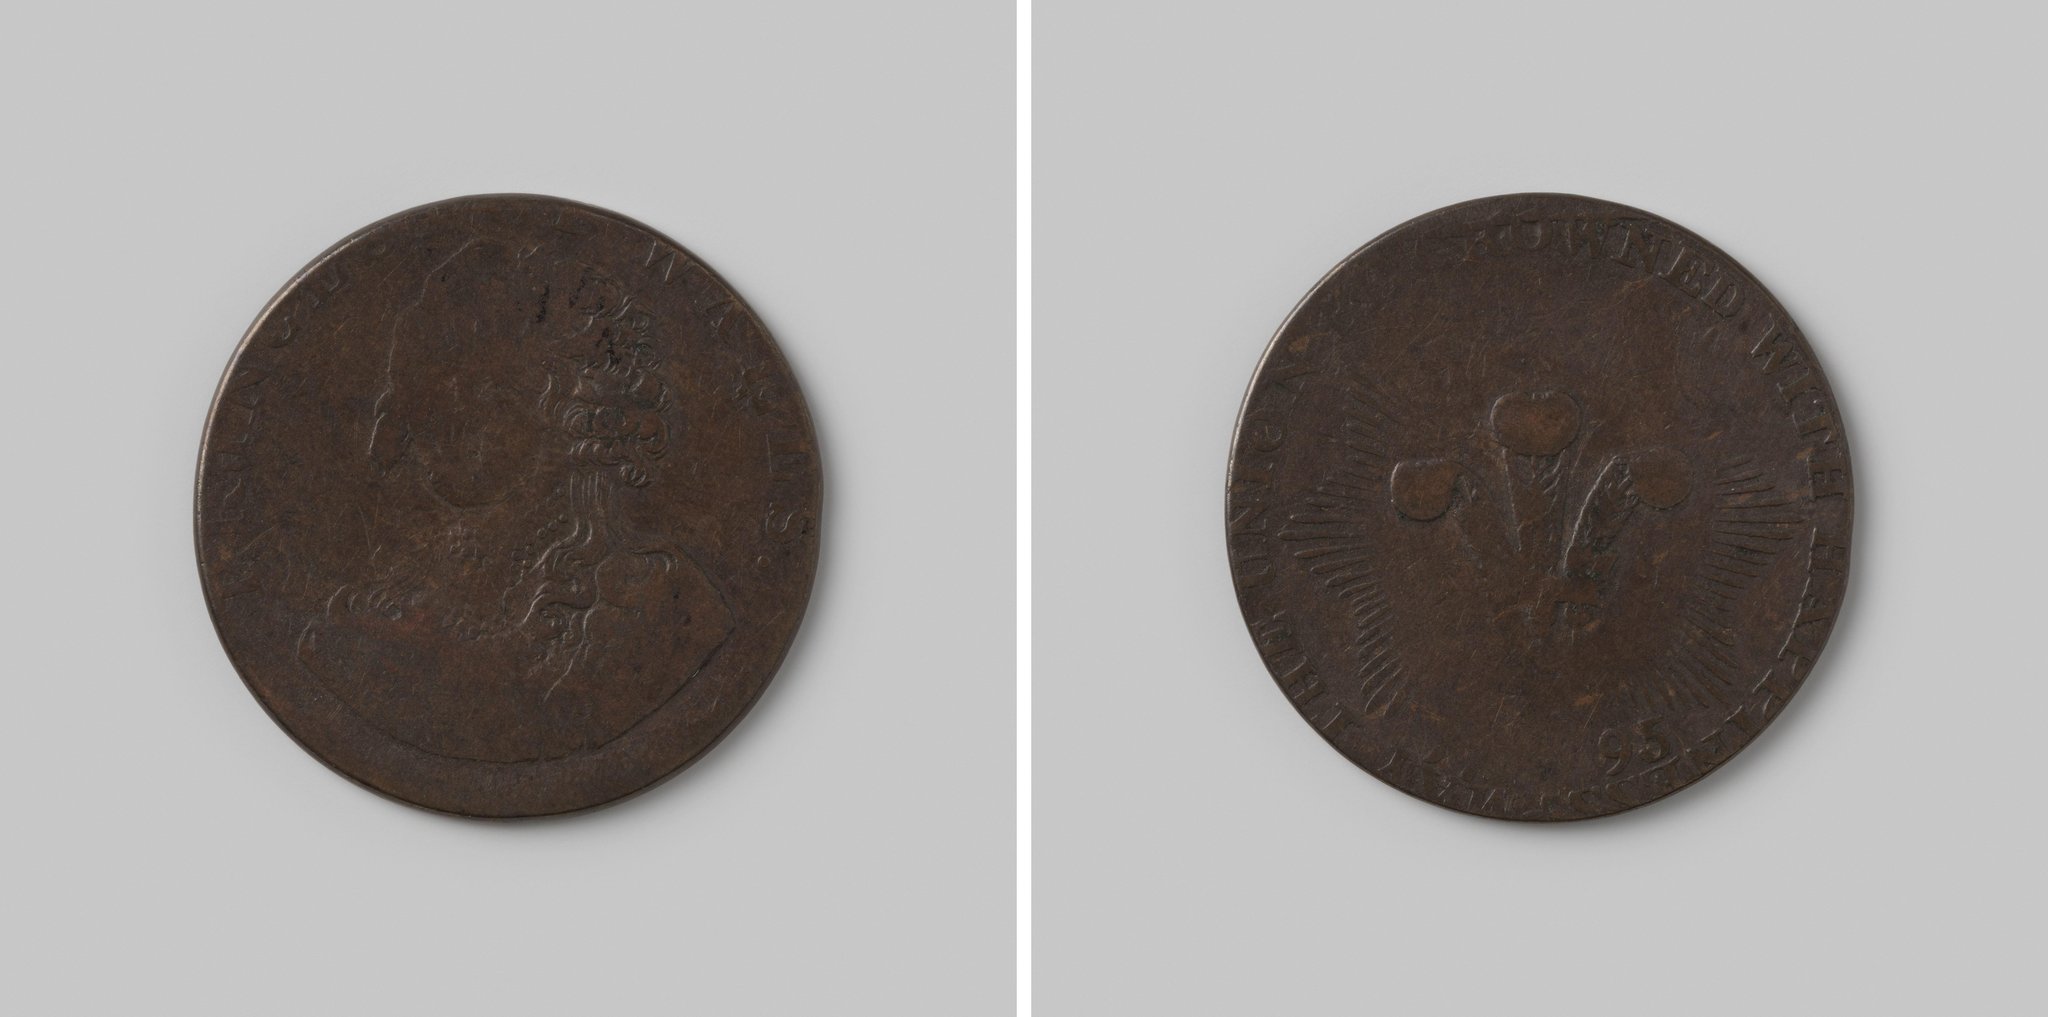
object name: history medal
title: Huwelijk van George Prins van Wales 1795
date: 1795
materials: copper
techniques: striking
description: Koperen penning, op de voorzijde het borstbeeld van Prins George half naar links met omschrift, op de keerzijde drie pauwenveren binnen een stralende ster met omschrift.